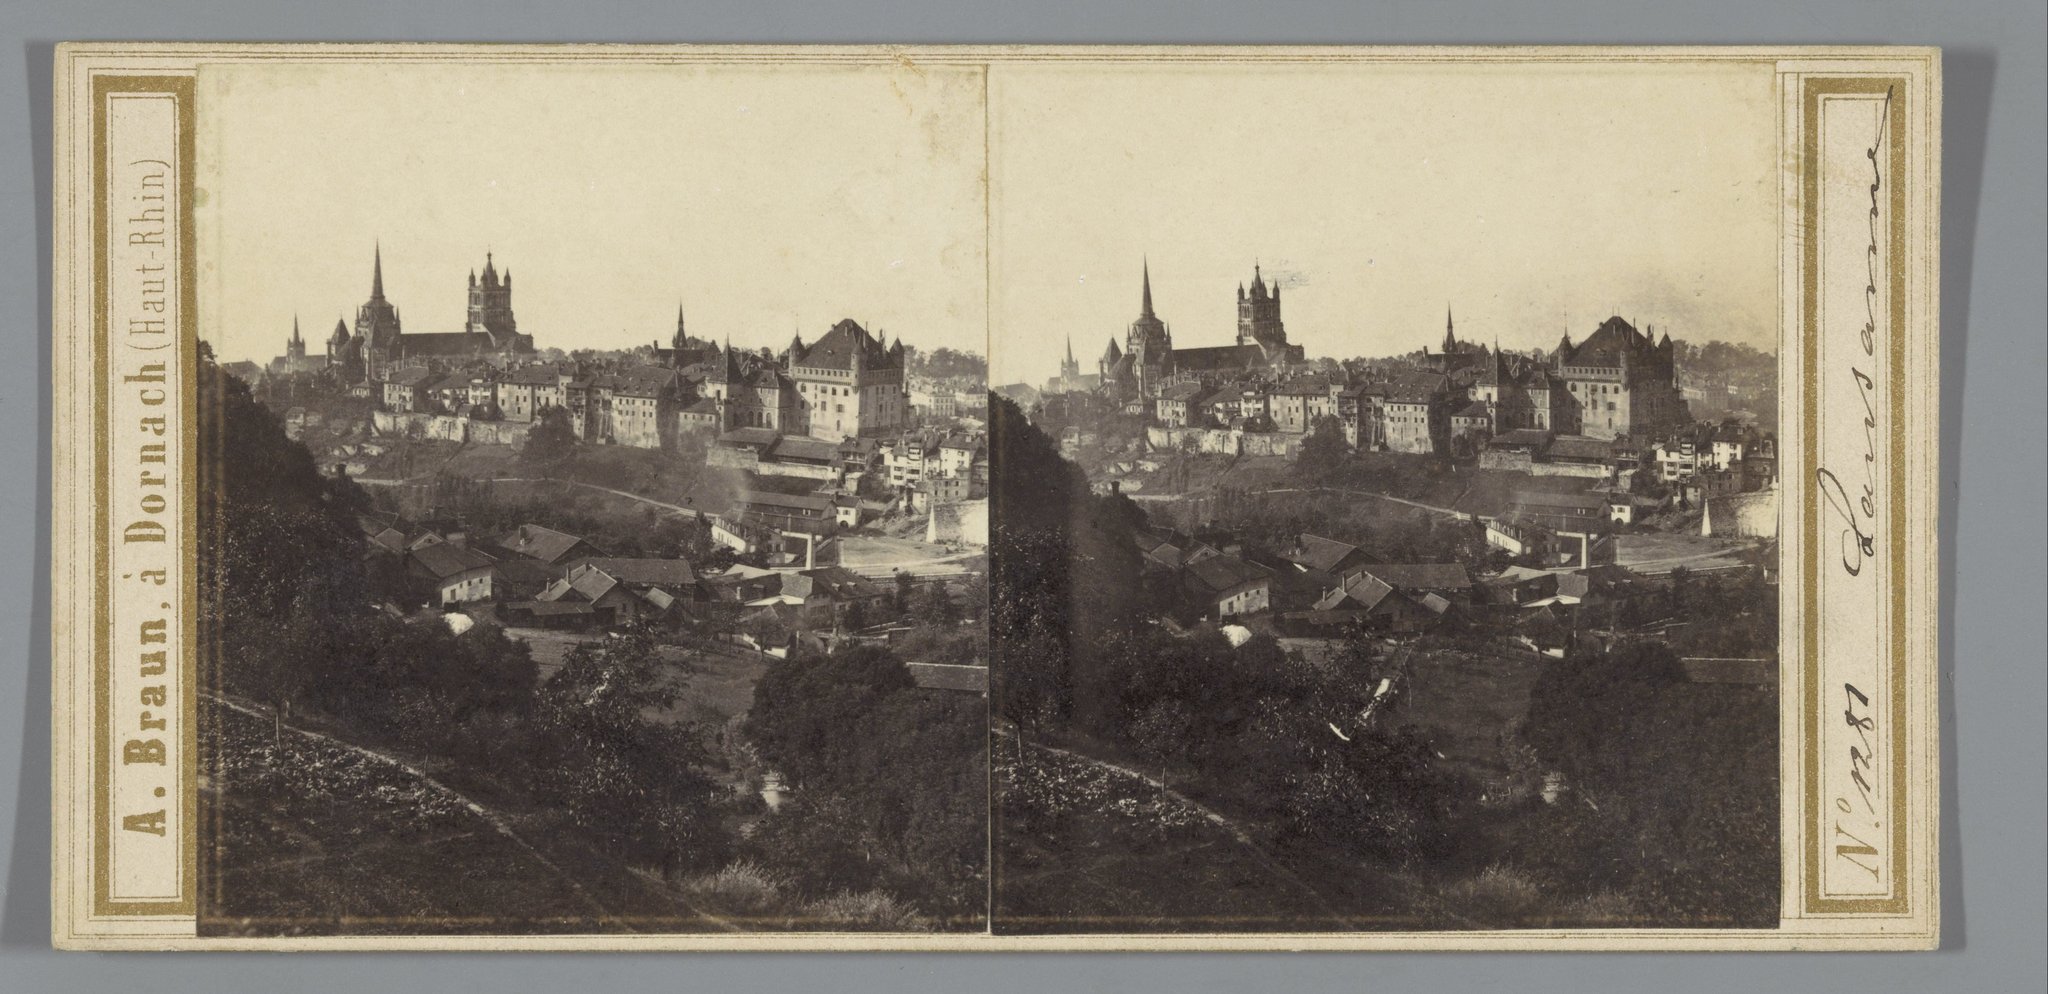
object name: stereograph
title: Lausanne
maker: Anonymous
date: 1860-1866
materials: cardboard, paper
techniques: albumen print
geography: lausanne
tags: city-view in general; 'veduta'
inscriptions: number: ‘No. 1281’